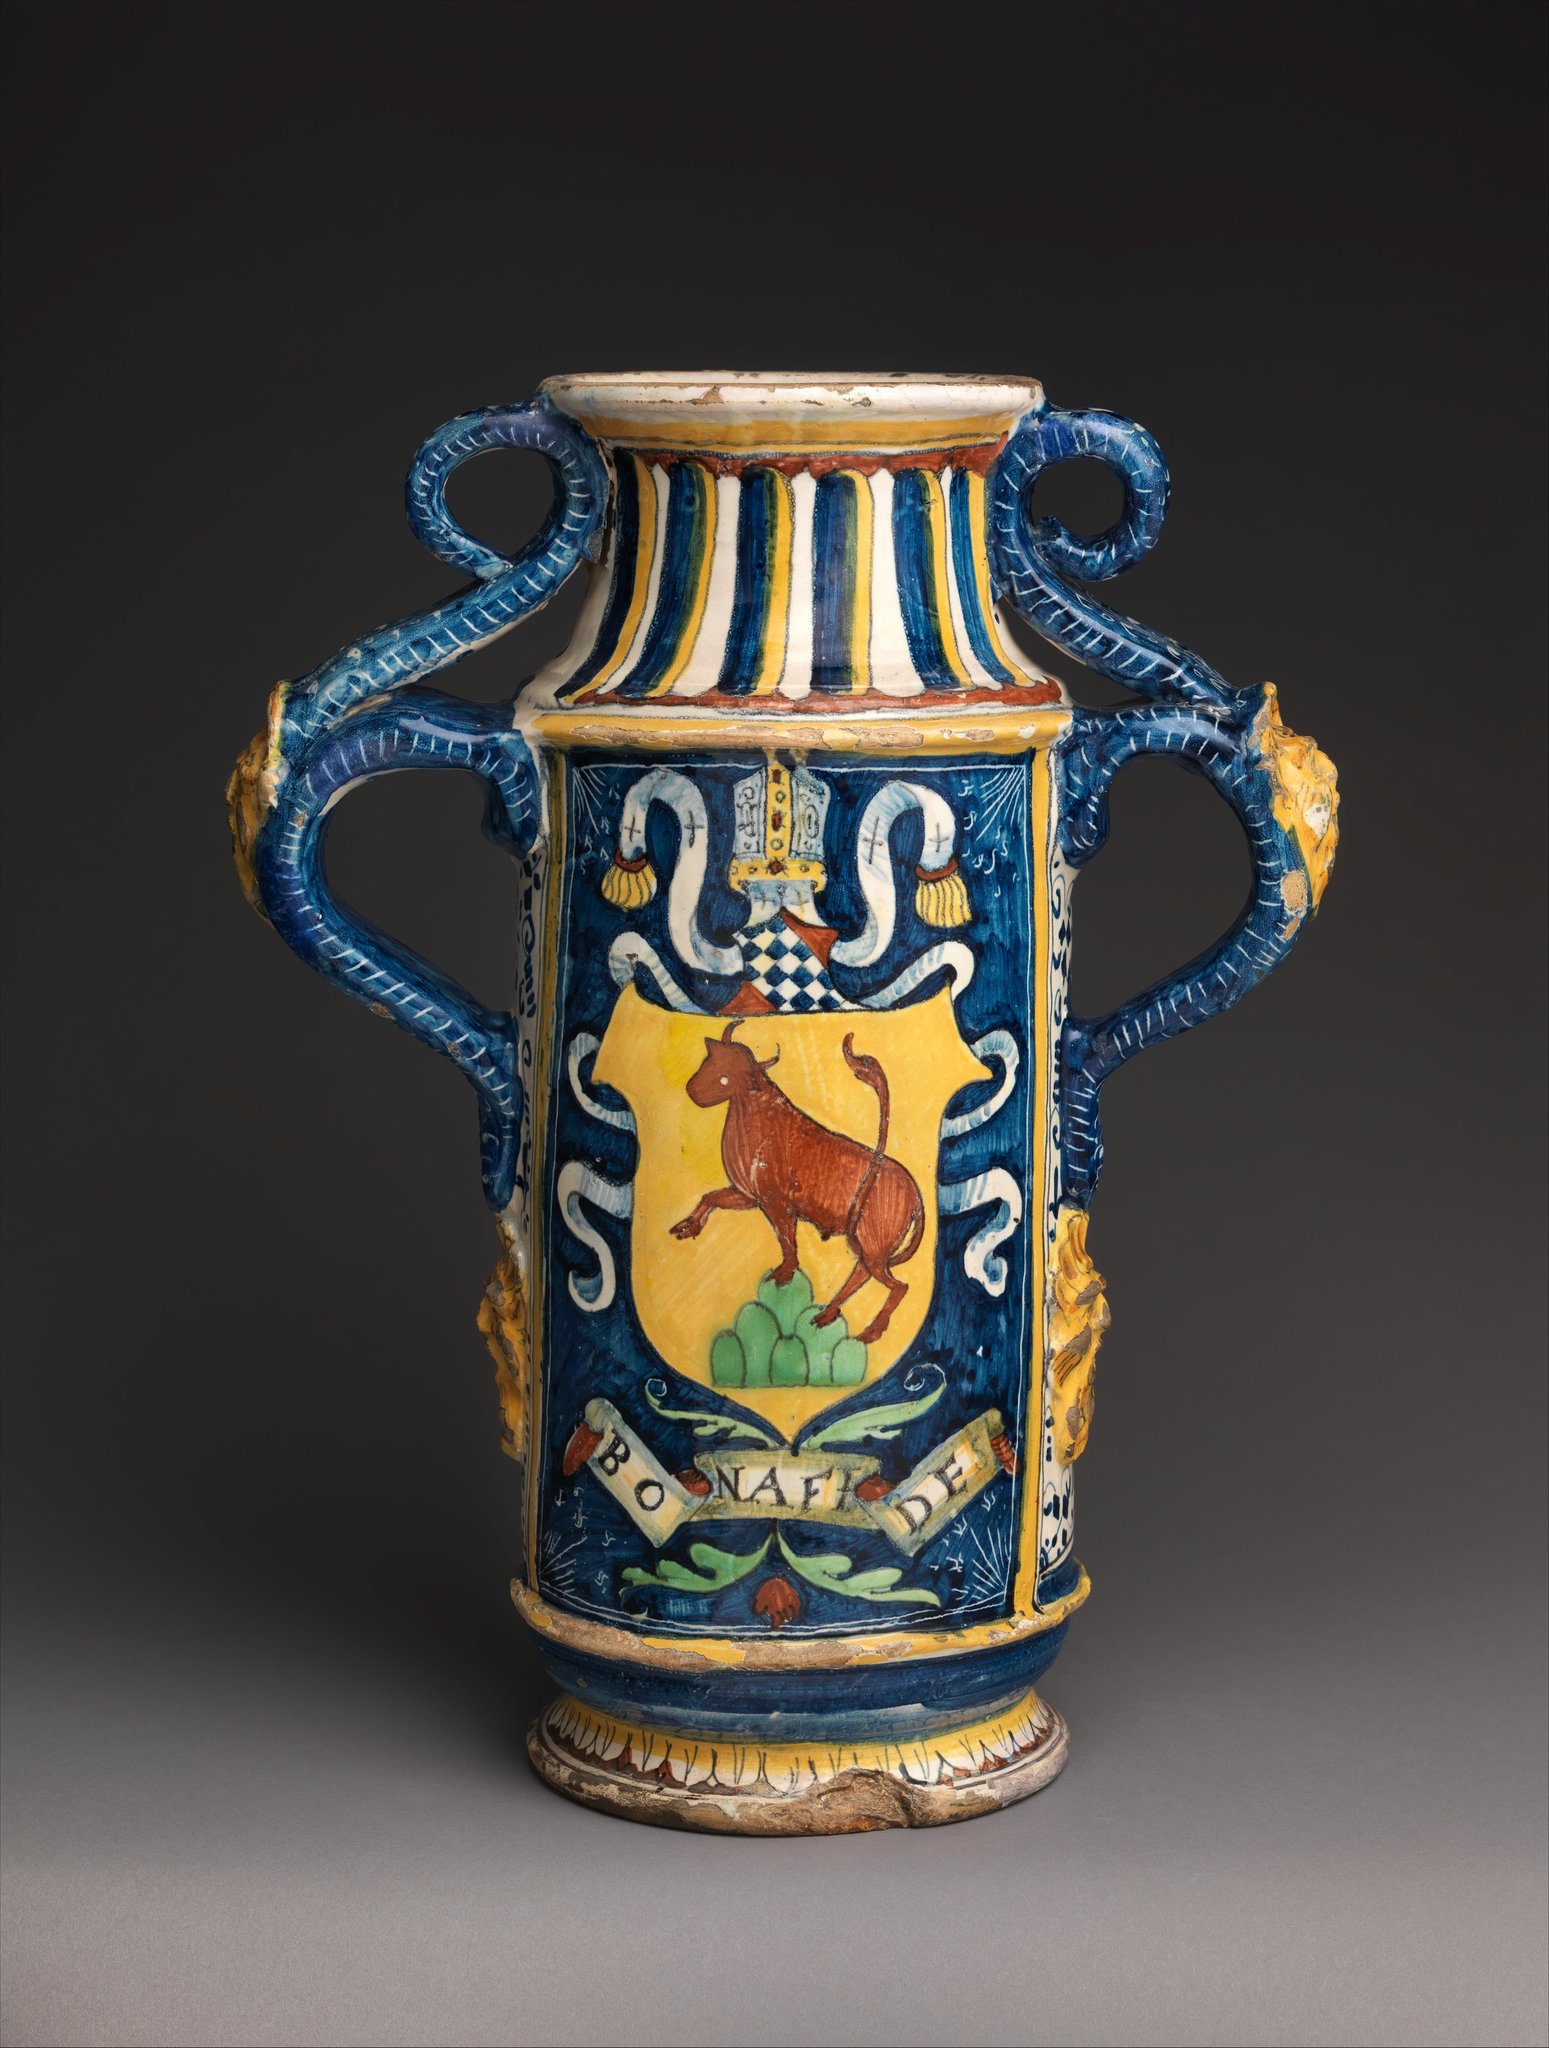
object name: jar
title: Albarello with arms of Leonardo Buonafede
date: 1525-1530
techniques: maiolica, glazing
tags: bulls,coat of arms